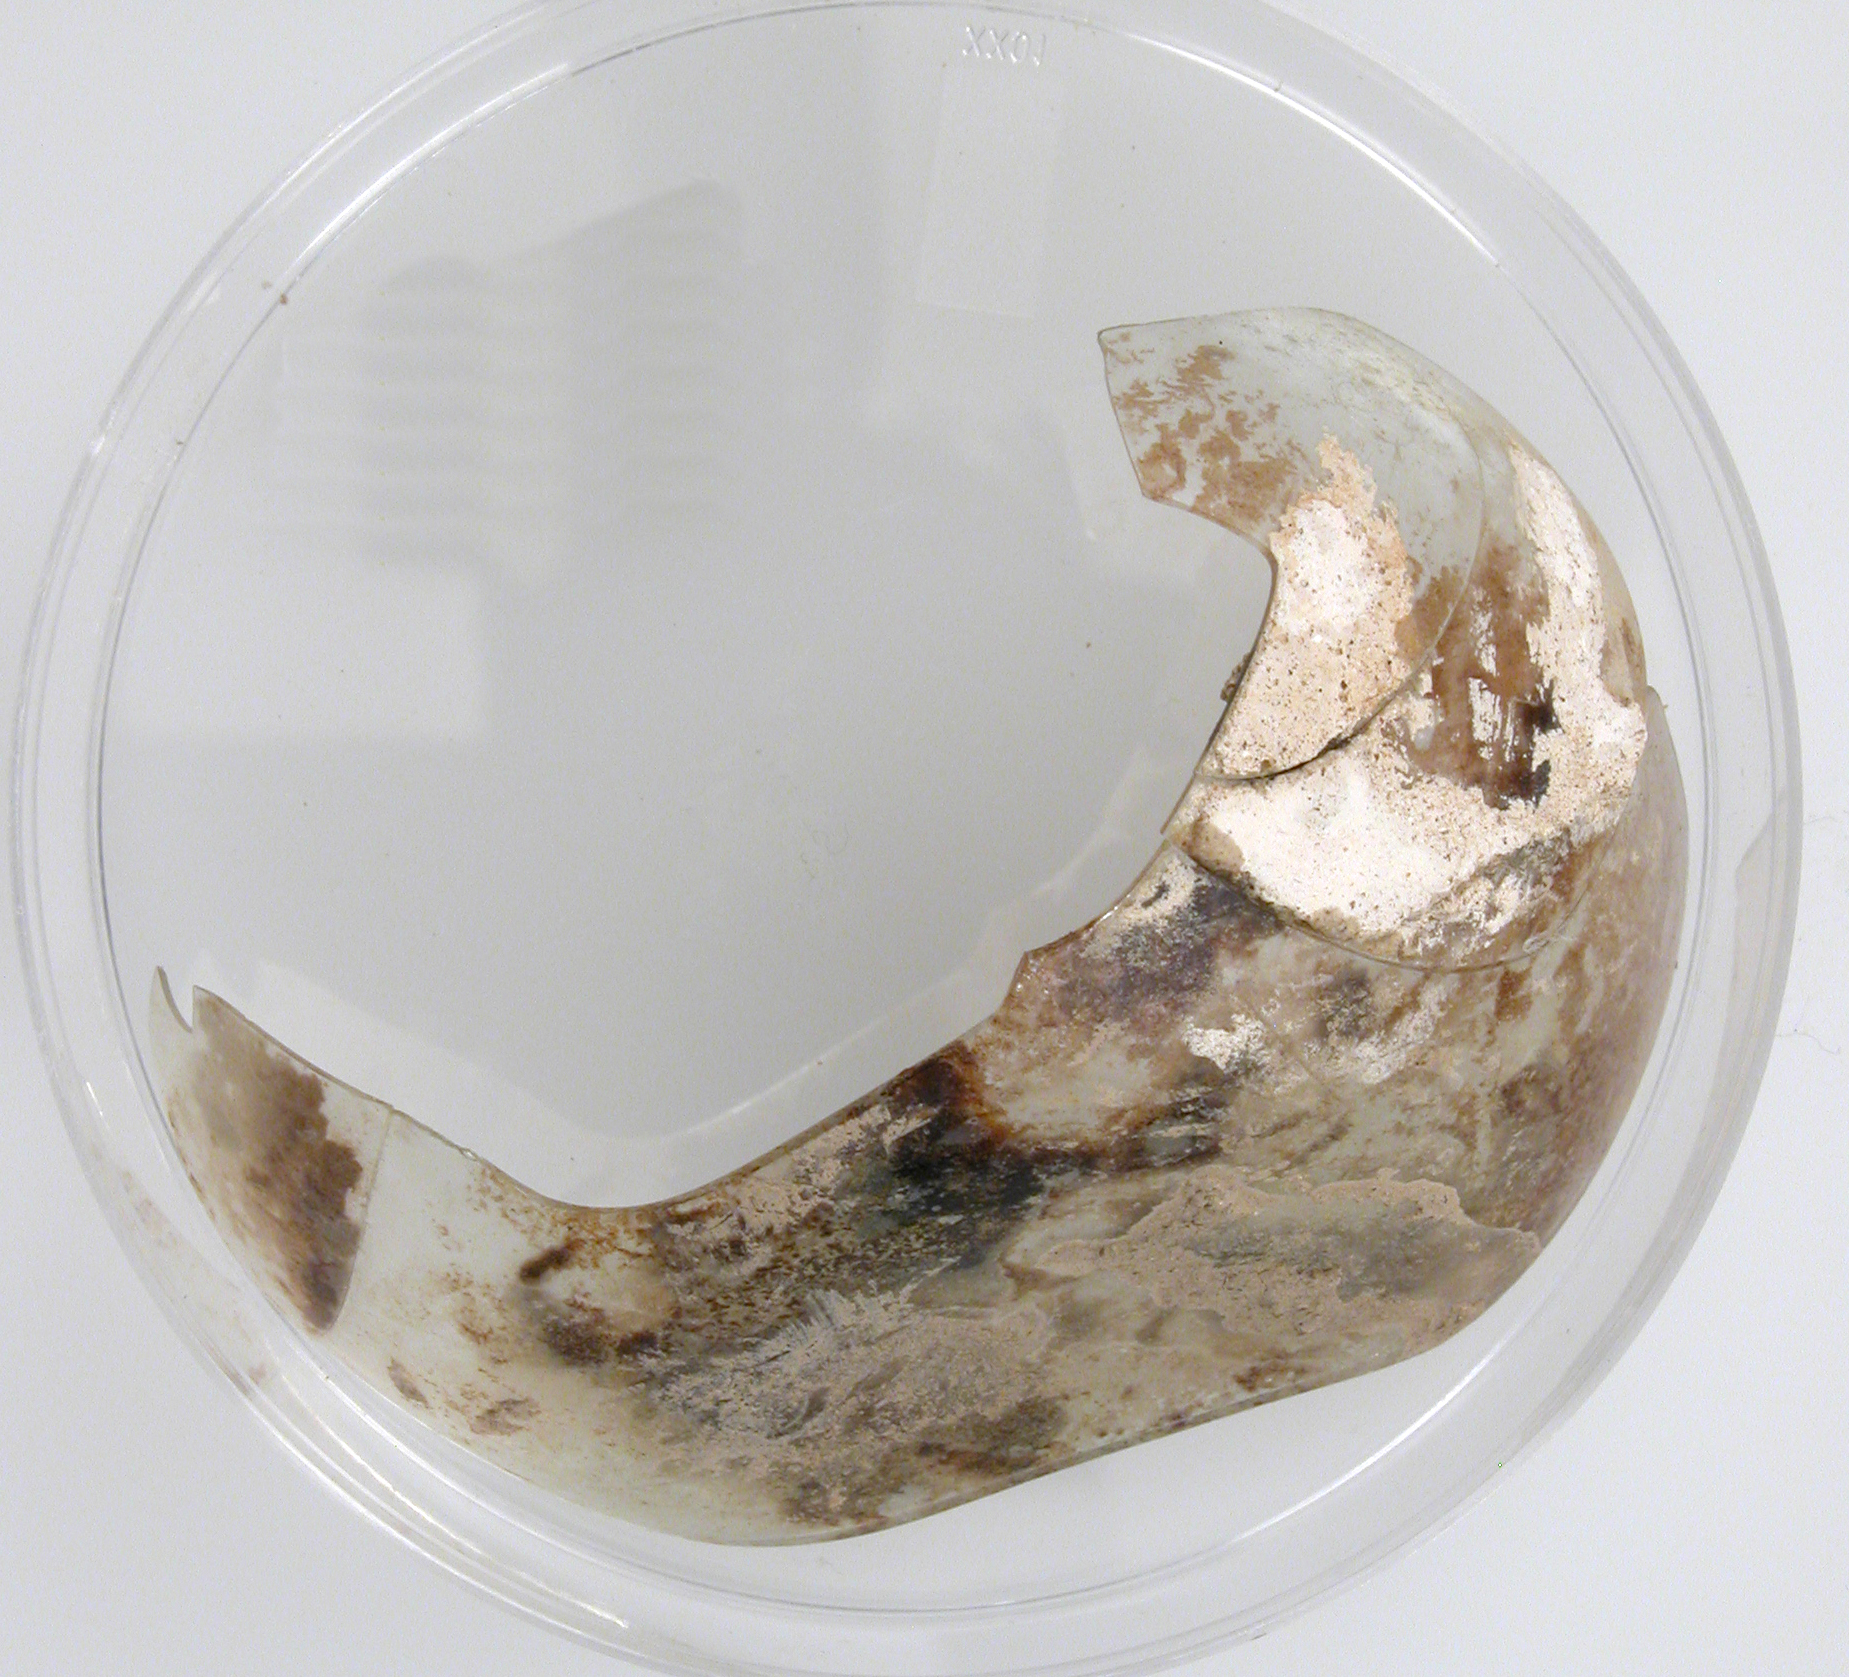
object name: fragment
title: Glass Fragment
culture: coptic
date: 301-400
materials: glass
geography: egypt